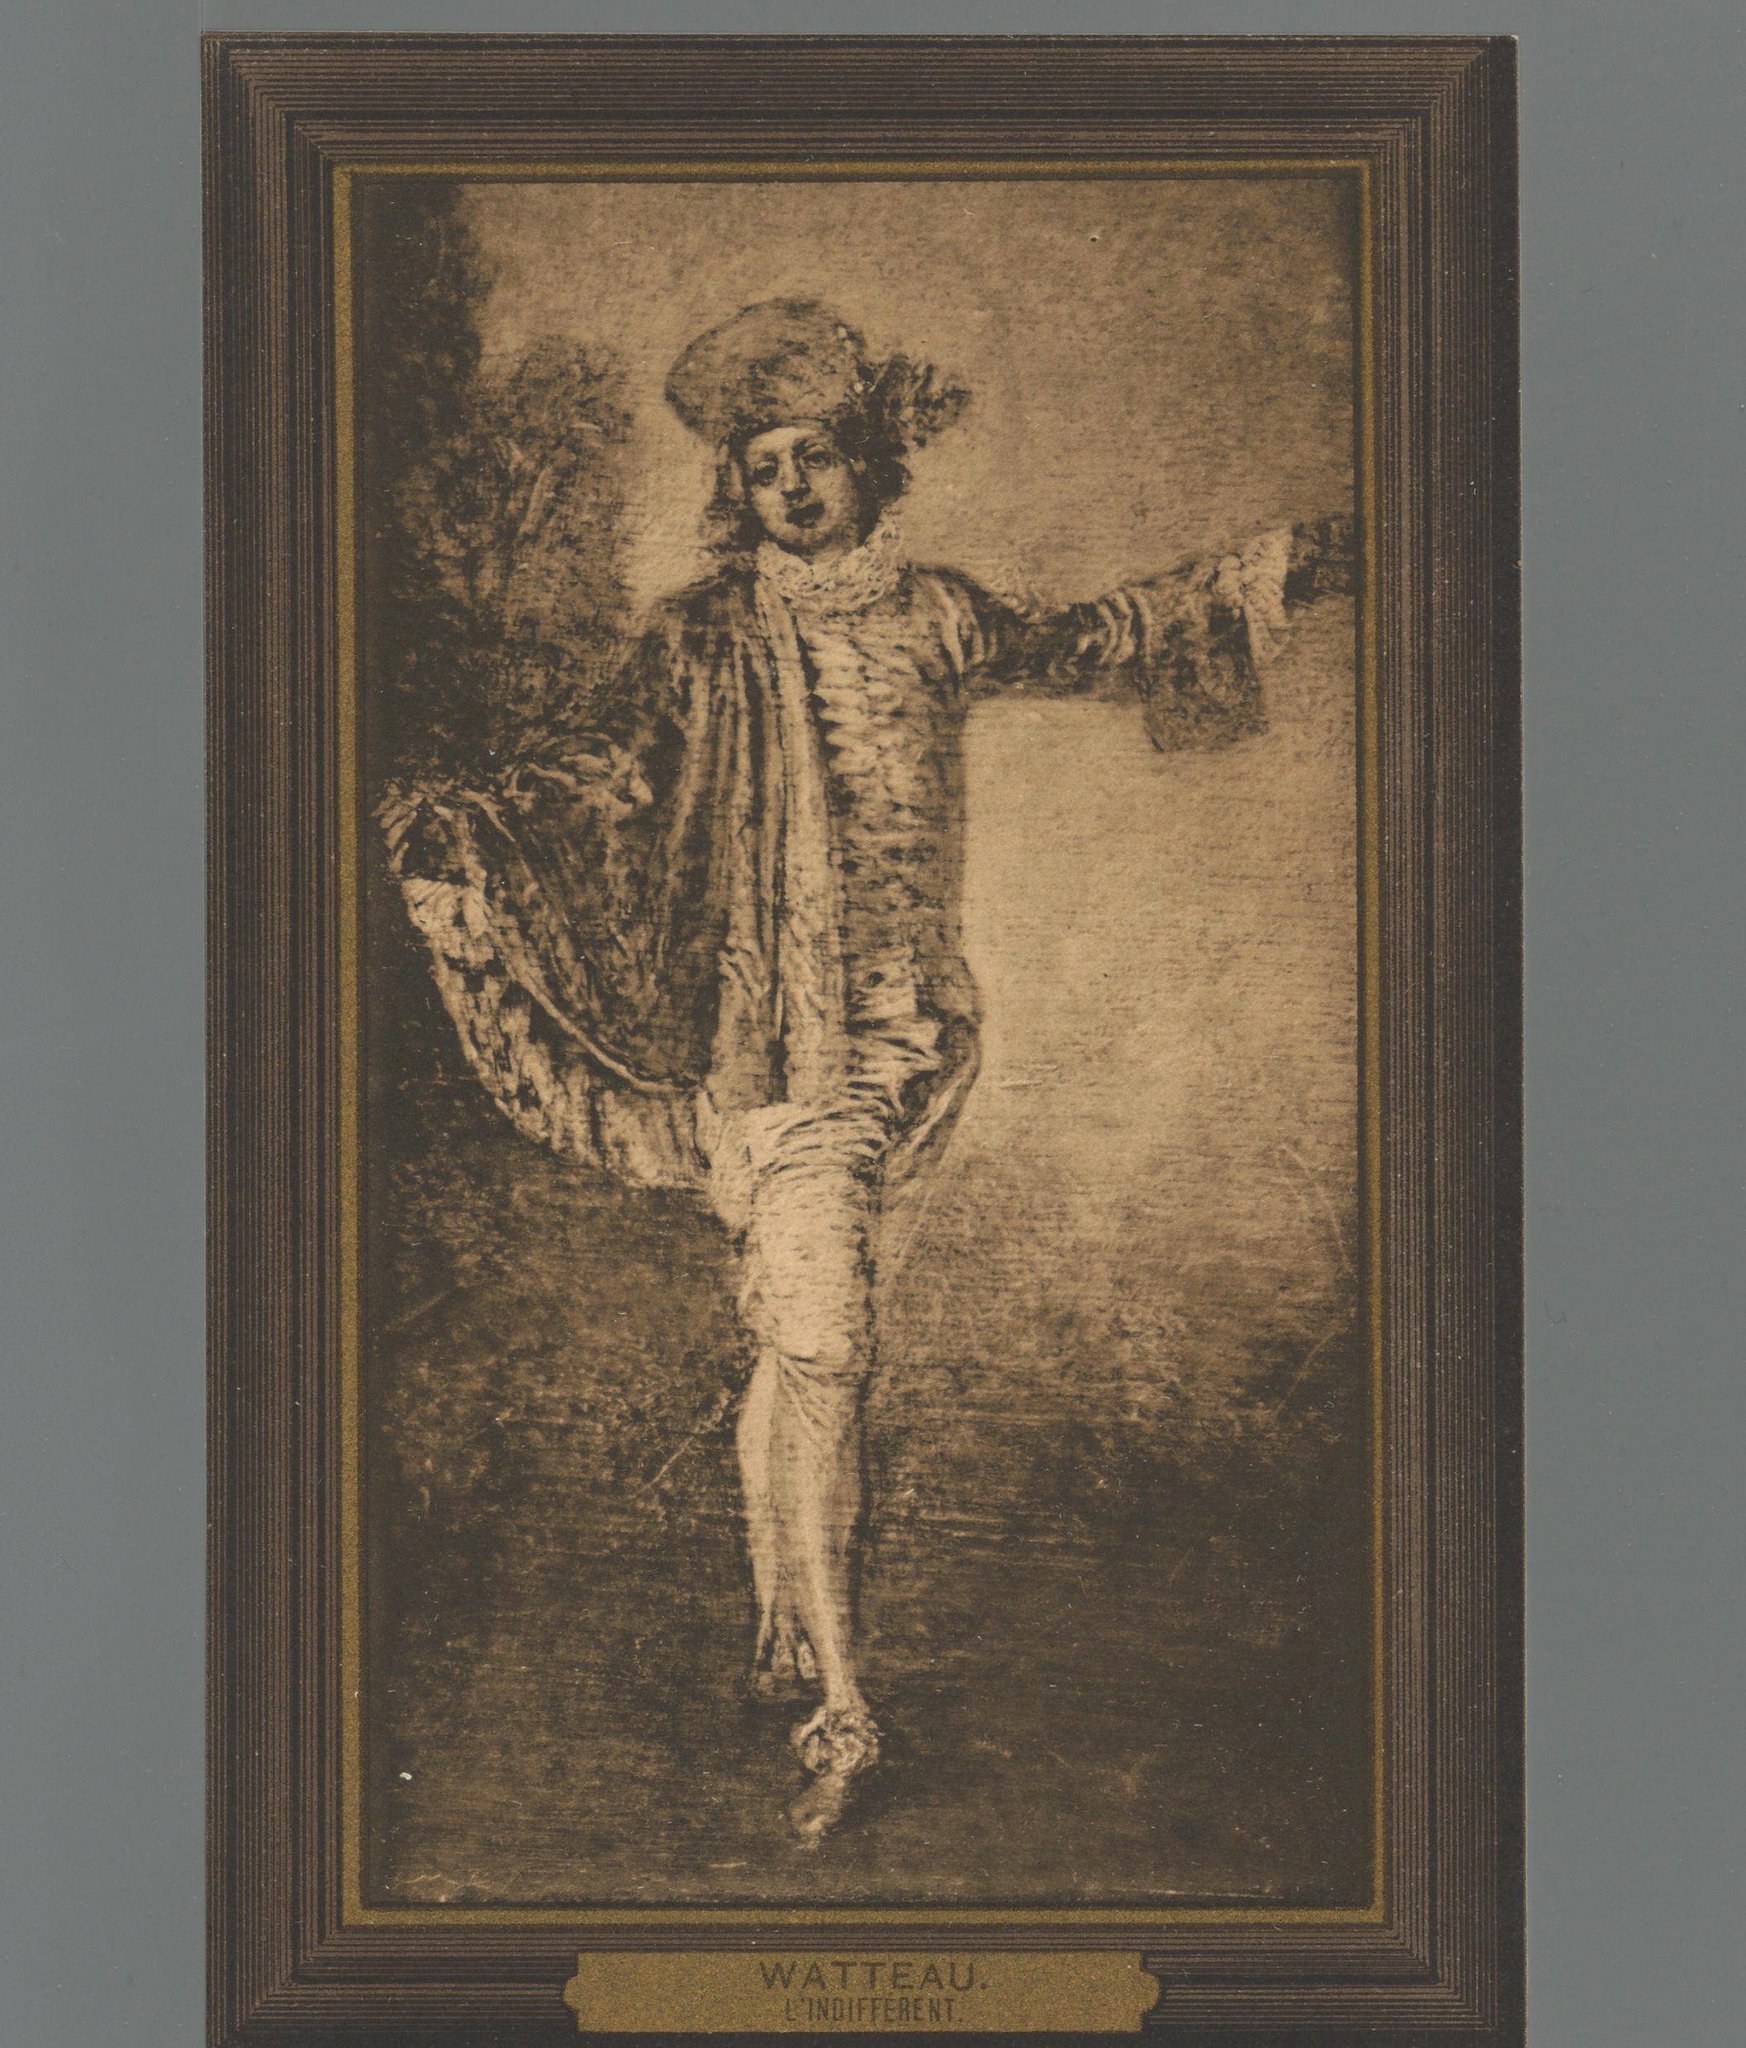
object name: reproduction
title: Watteau. L'indifférent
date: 1903-1930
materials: cardboard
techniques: photograph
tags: permanent exhibition, museum, picture, painting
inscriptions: collector's mark: ‘AFE v S’, inscription: ‘L. N. Musée du Louvre’